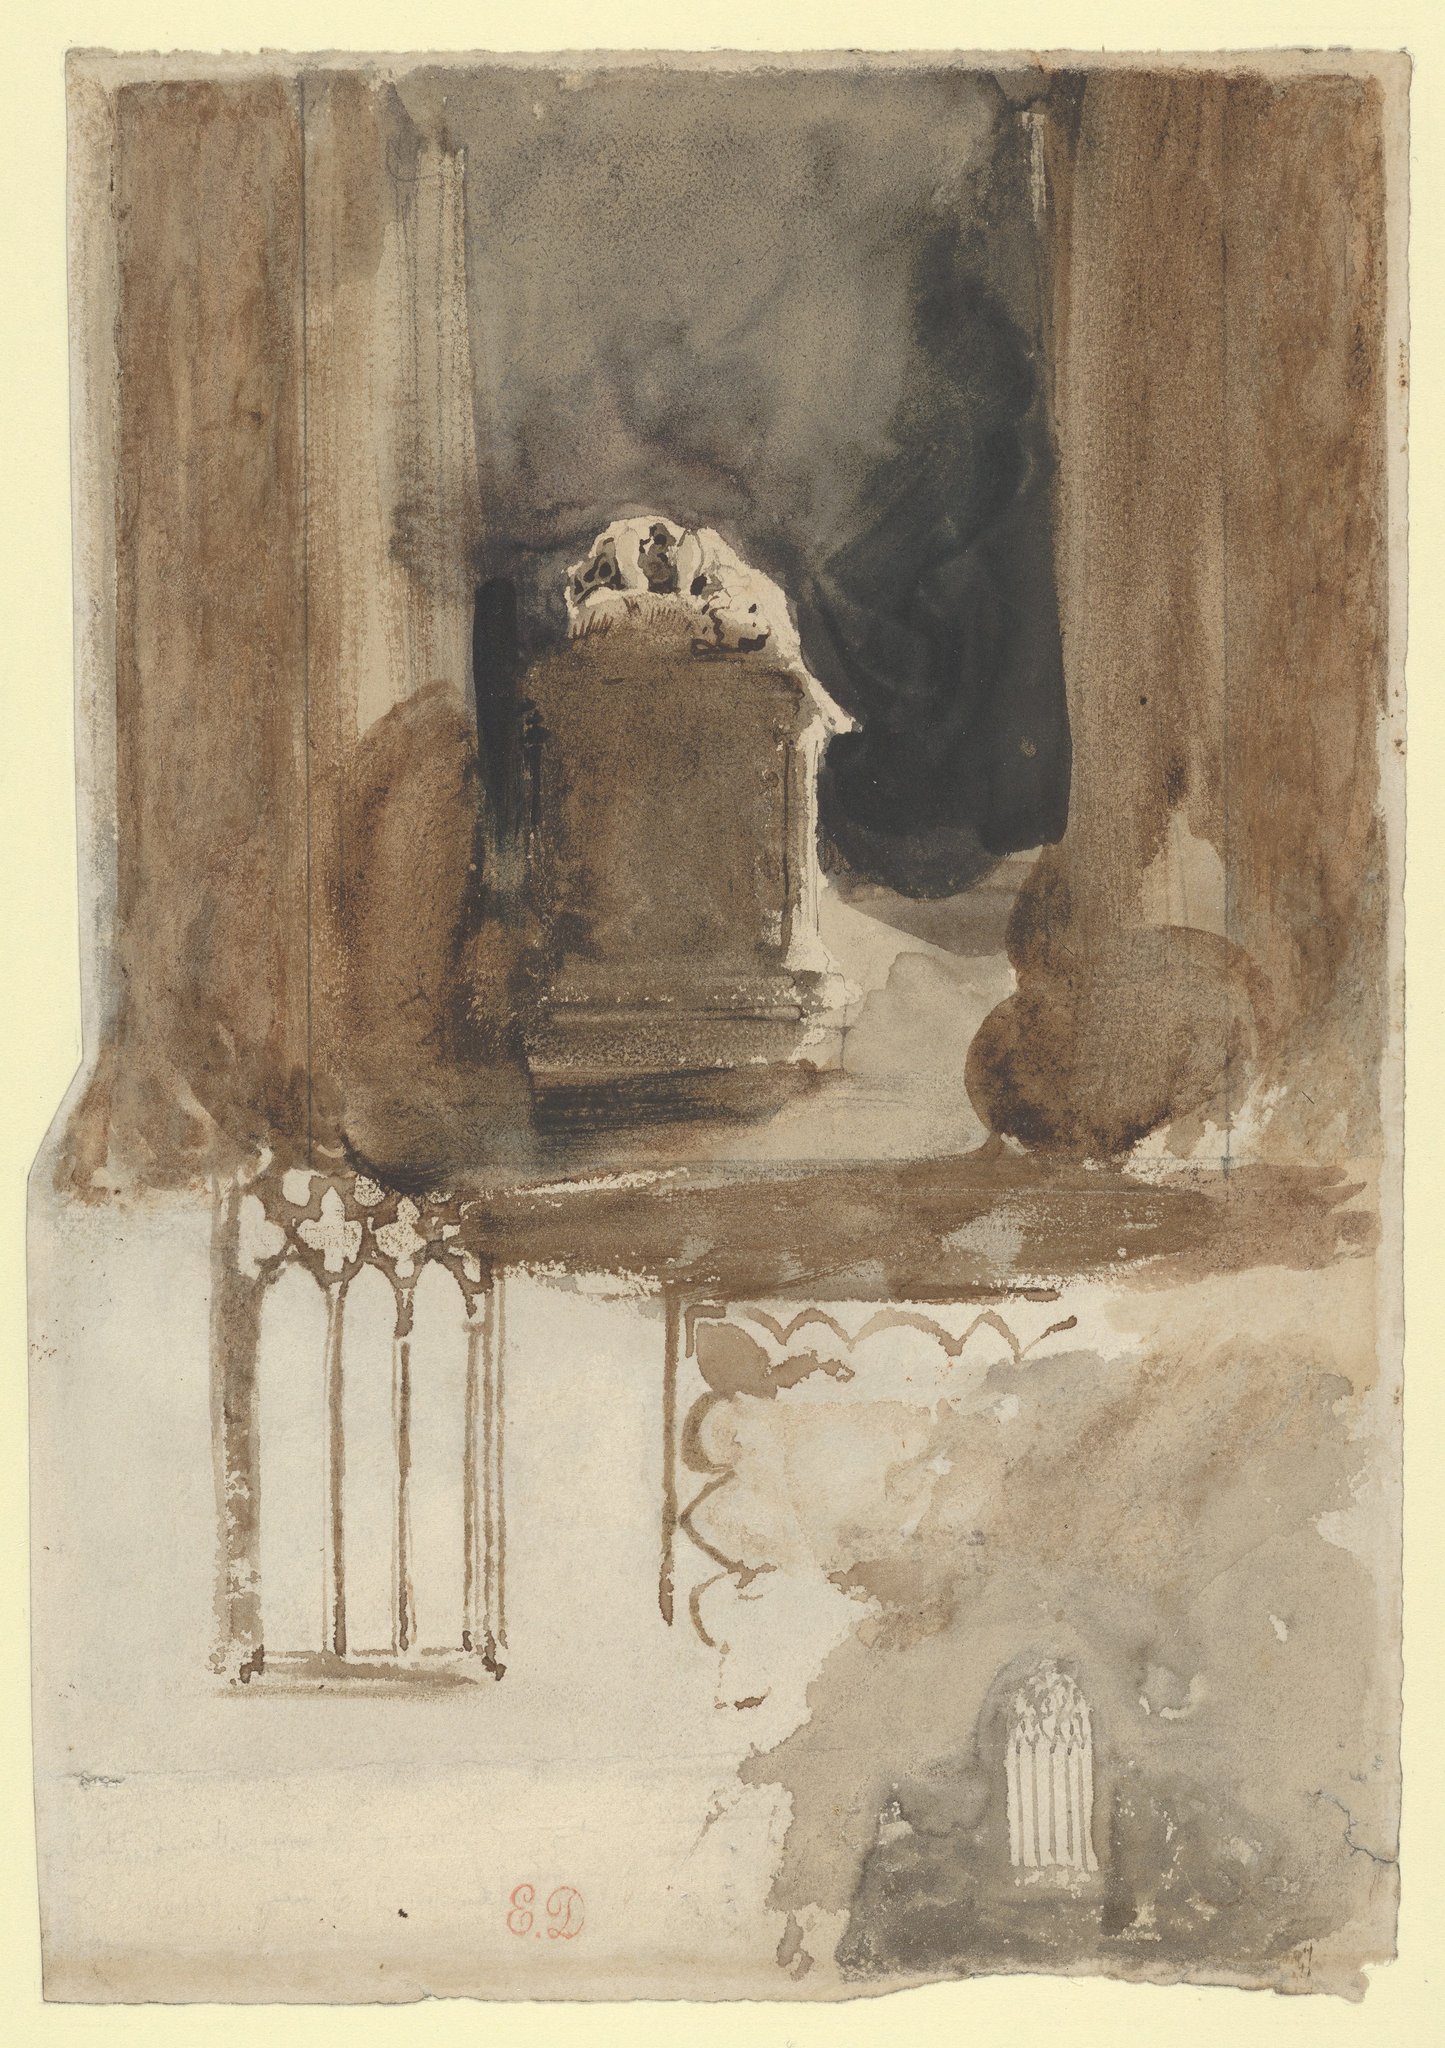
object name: drawing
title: A Tomb and Studies of Windows in the Church of Valmont Abbey (recto); Four Studies of Horses (verso)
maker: eugène delacroix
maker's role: artist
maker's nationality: french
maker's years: 1798-1863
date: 1829-1831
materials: graphite, ink, paper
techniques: brush, wash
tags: tombs,horses